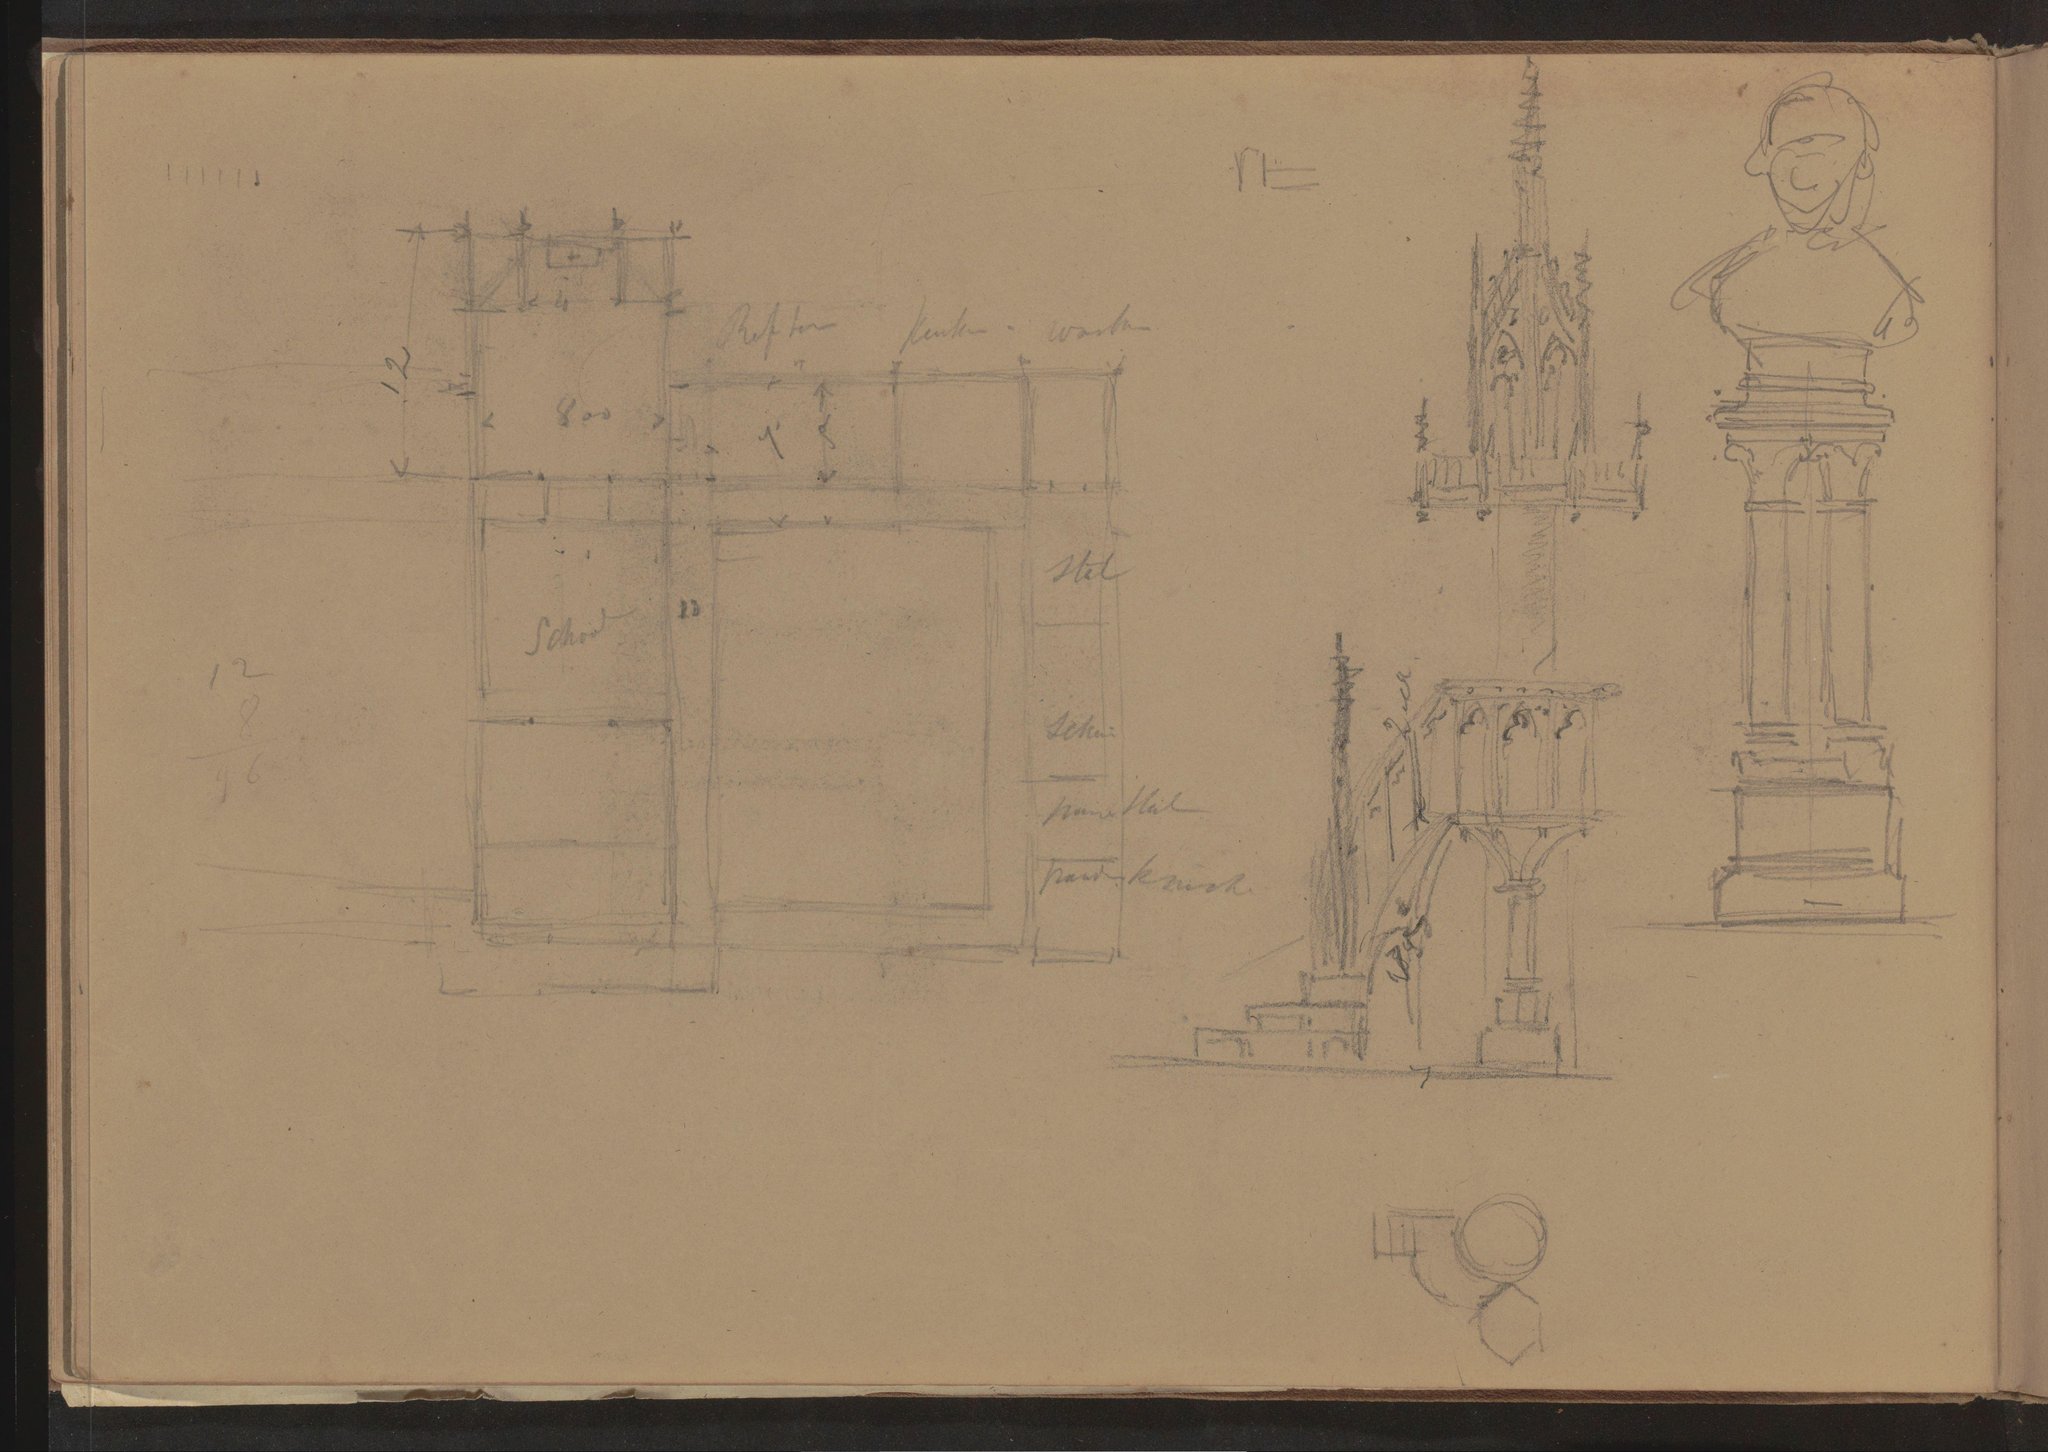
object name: sketchbook leaf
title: Plattegrond, een preekstoel en een buste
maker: pierre joseph hubert cuypers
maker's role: draughtsman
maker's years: 1827-1921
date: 1837-1921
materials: paper, pencil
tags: pulpit, ambo, chancel, monument, statue, plan ~ architecture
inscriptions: annotation: ‘[...] refter keuken was[...]/ school/ [...]’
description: Blad 12 verso uit een schetsboek met 23 bladen.